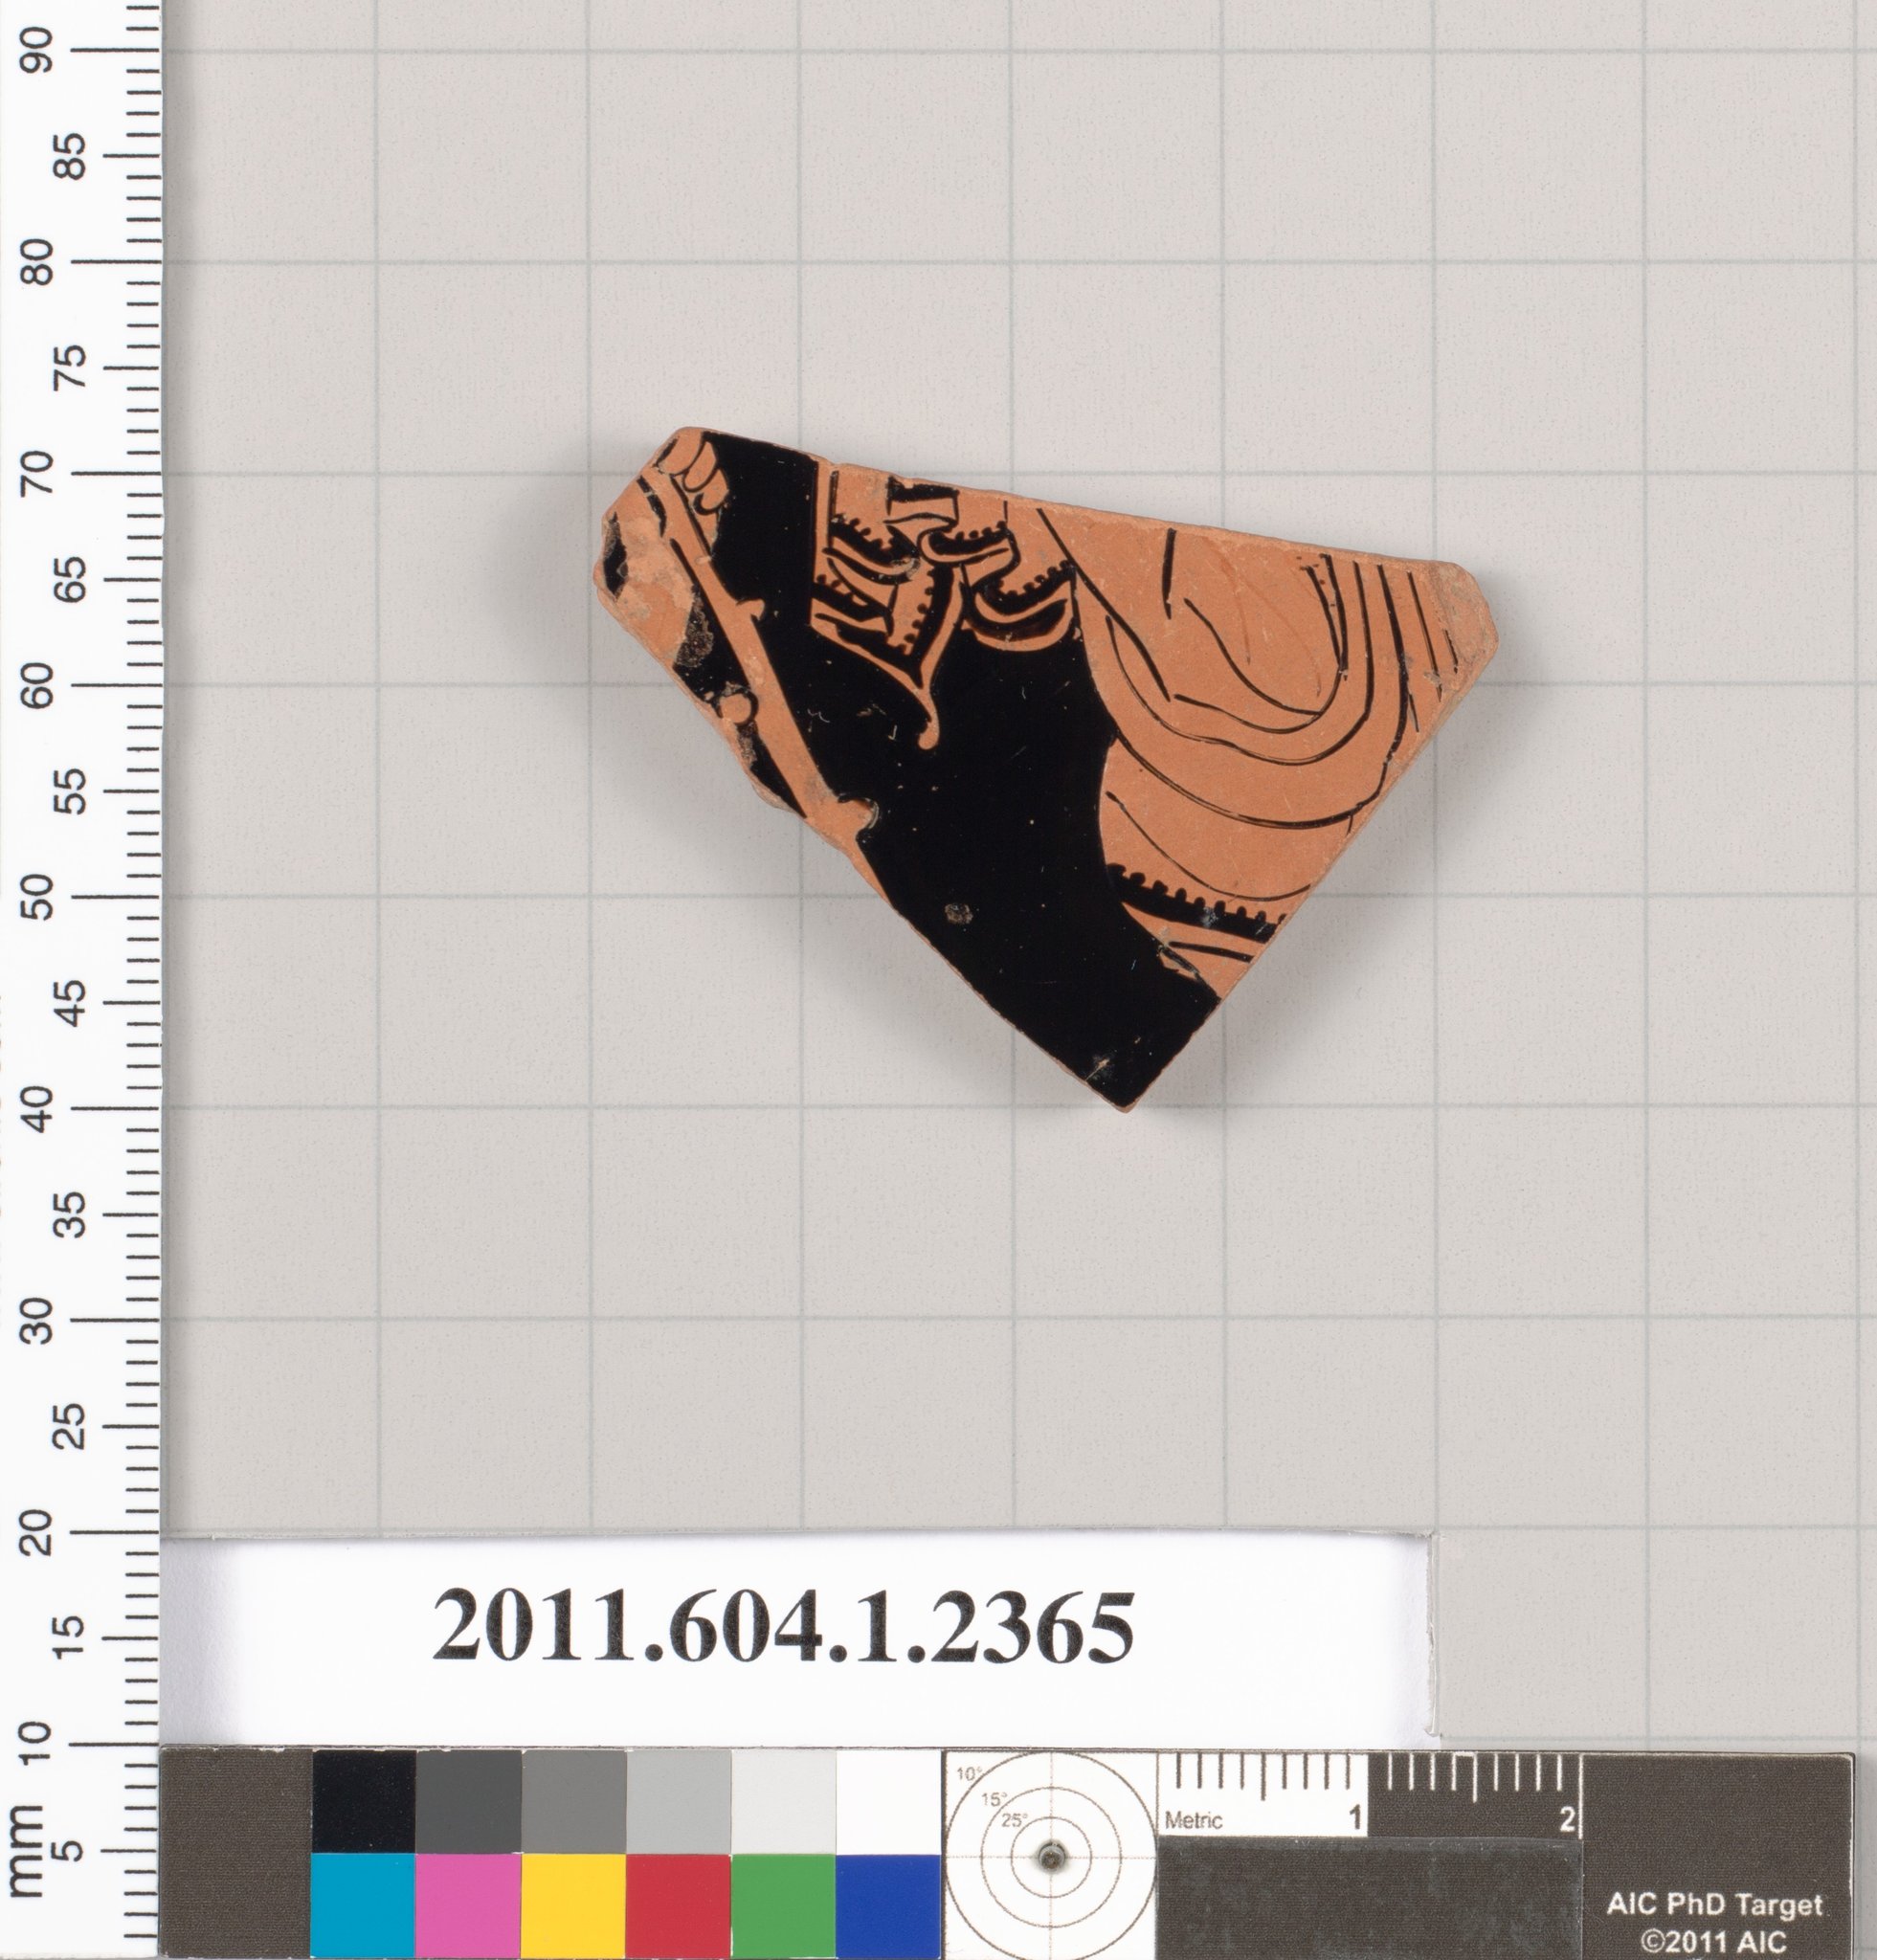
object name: kylix fragment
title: Terracotta fragment of a kylix (drinking cup)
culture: greek, attic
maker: painter of the paris gigantomachy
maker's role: artist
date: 490-480 BCE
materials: terracotta